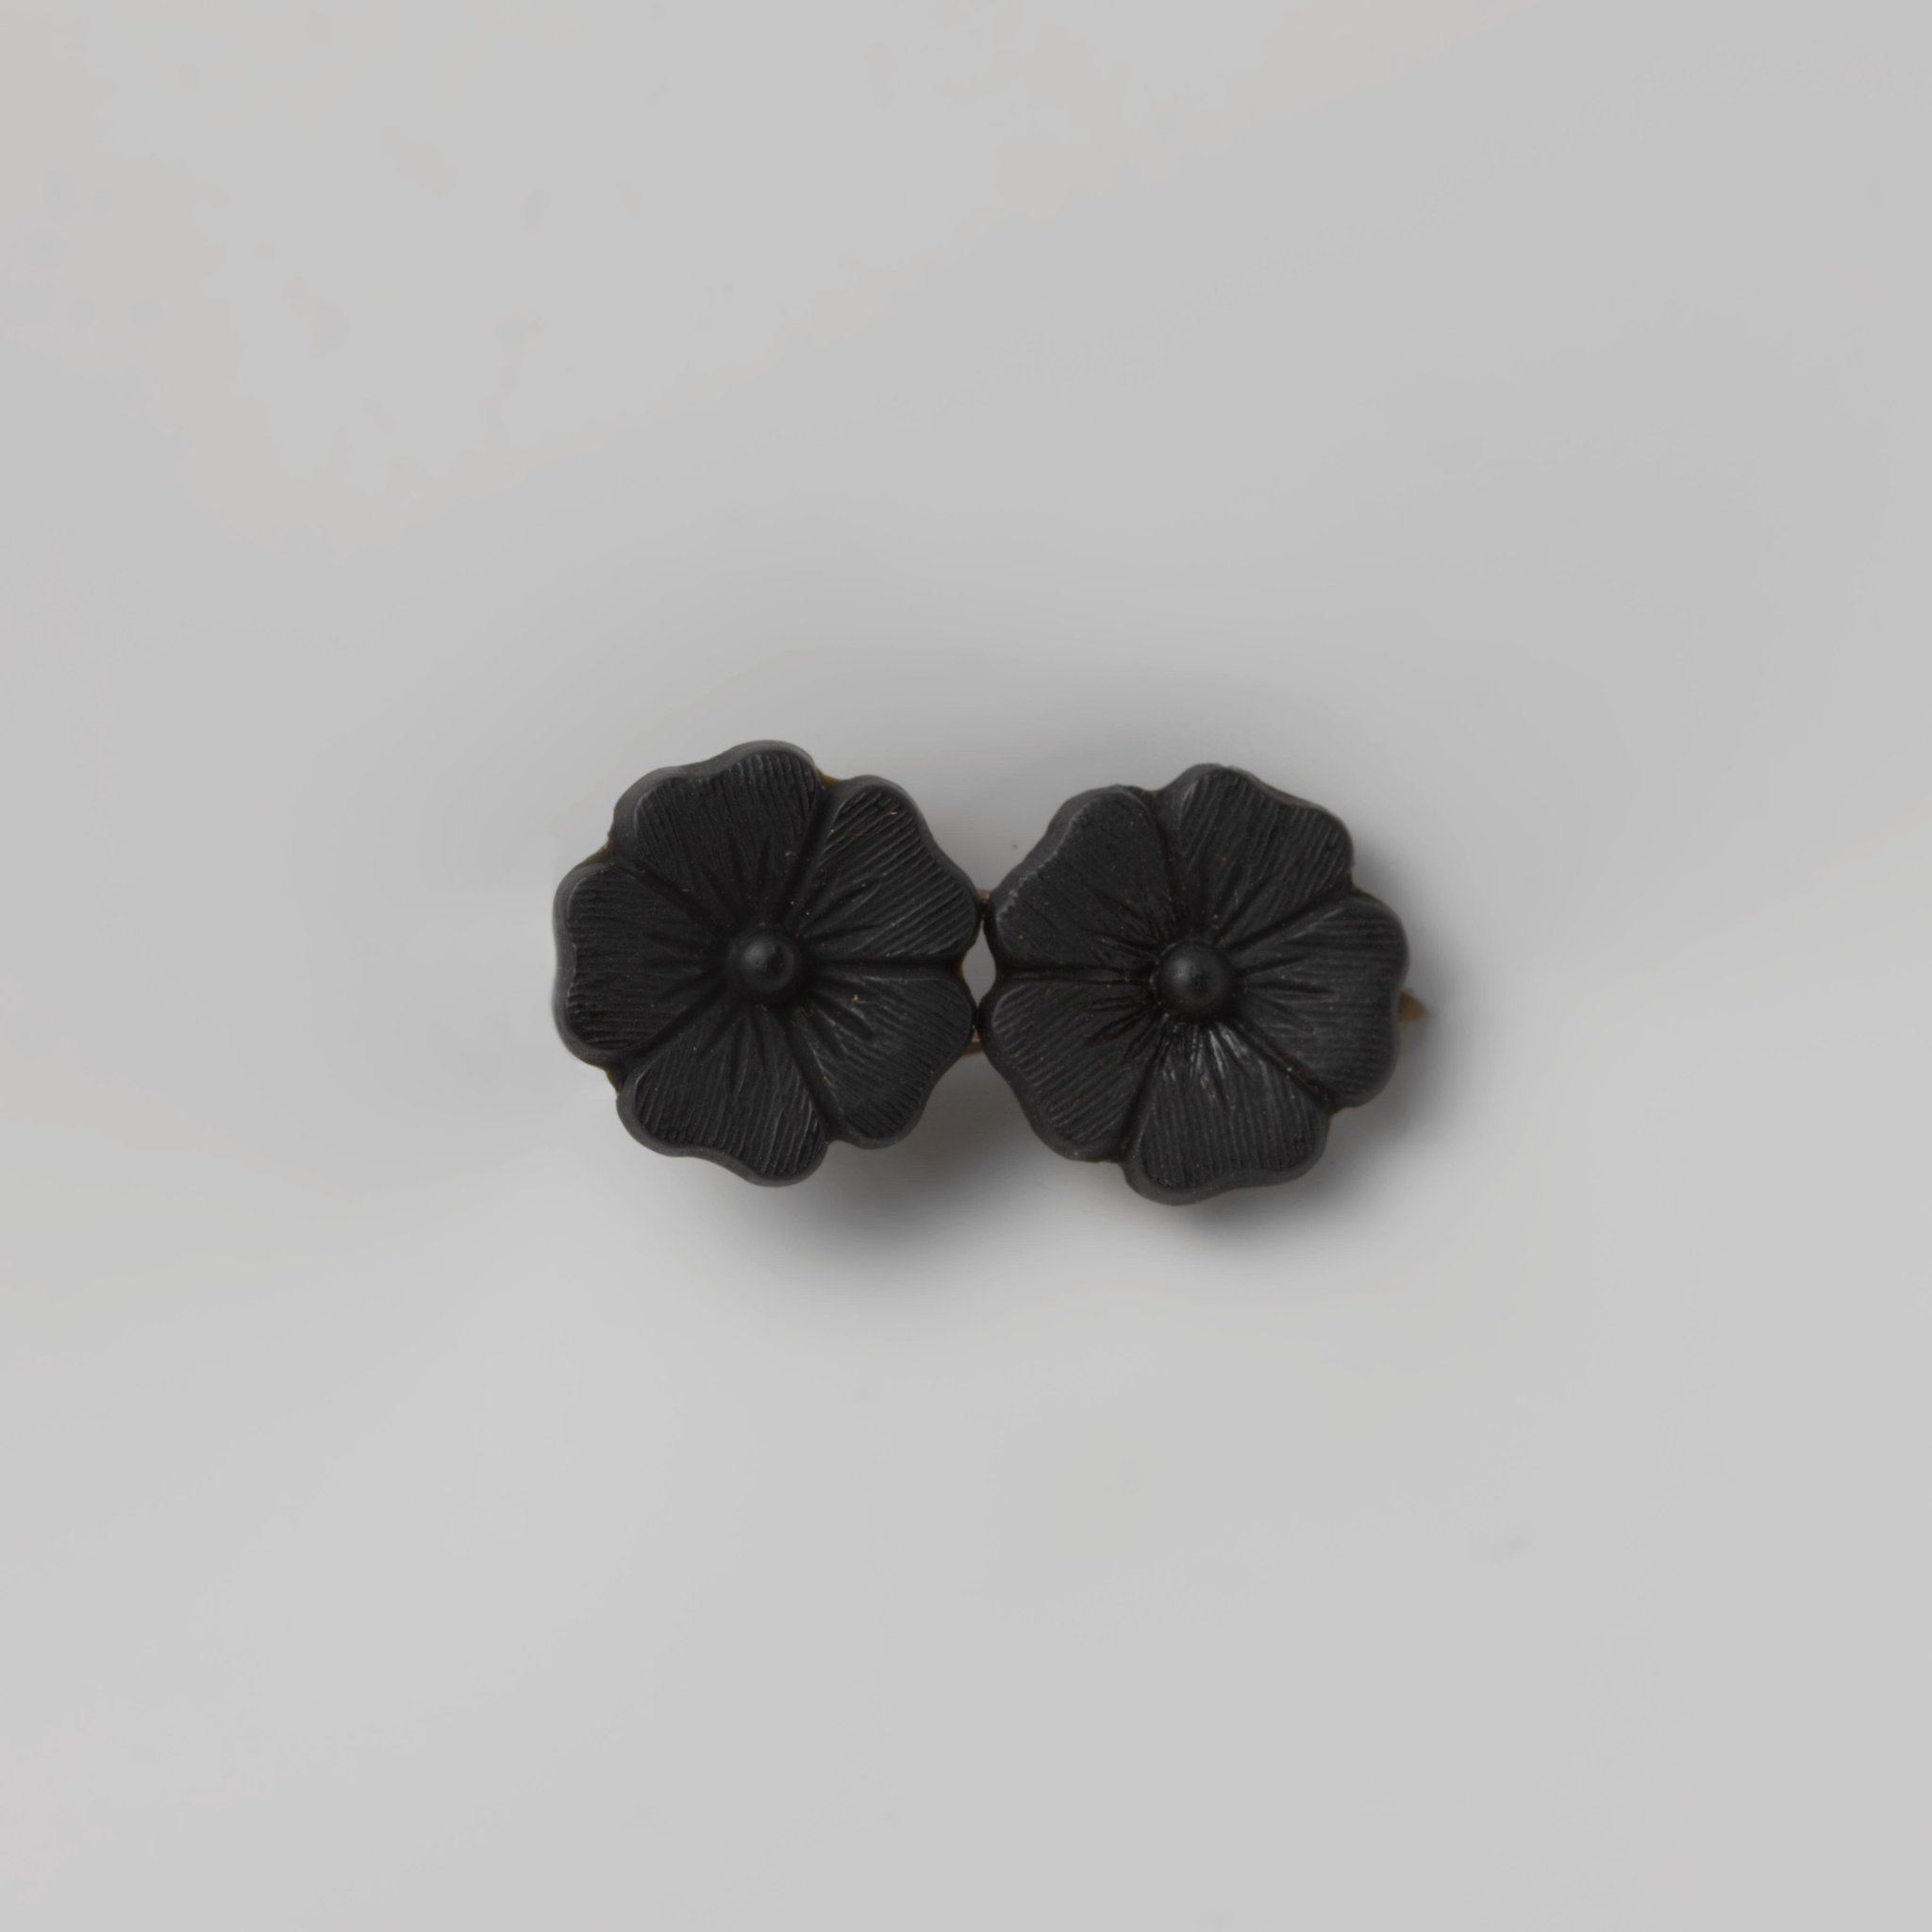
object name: brooch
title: Rouwbroche met twee bloemen van zwart glas op zilveren brochering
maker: Anonymous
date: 1880-1900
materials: glass, silver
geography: schoonhoven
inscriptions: alloy mark: ‘oud zwaard’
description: Rouwbroche met twee bloemen van zwart glas op een zilveren brochering voorzien van een haaksluiting.